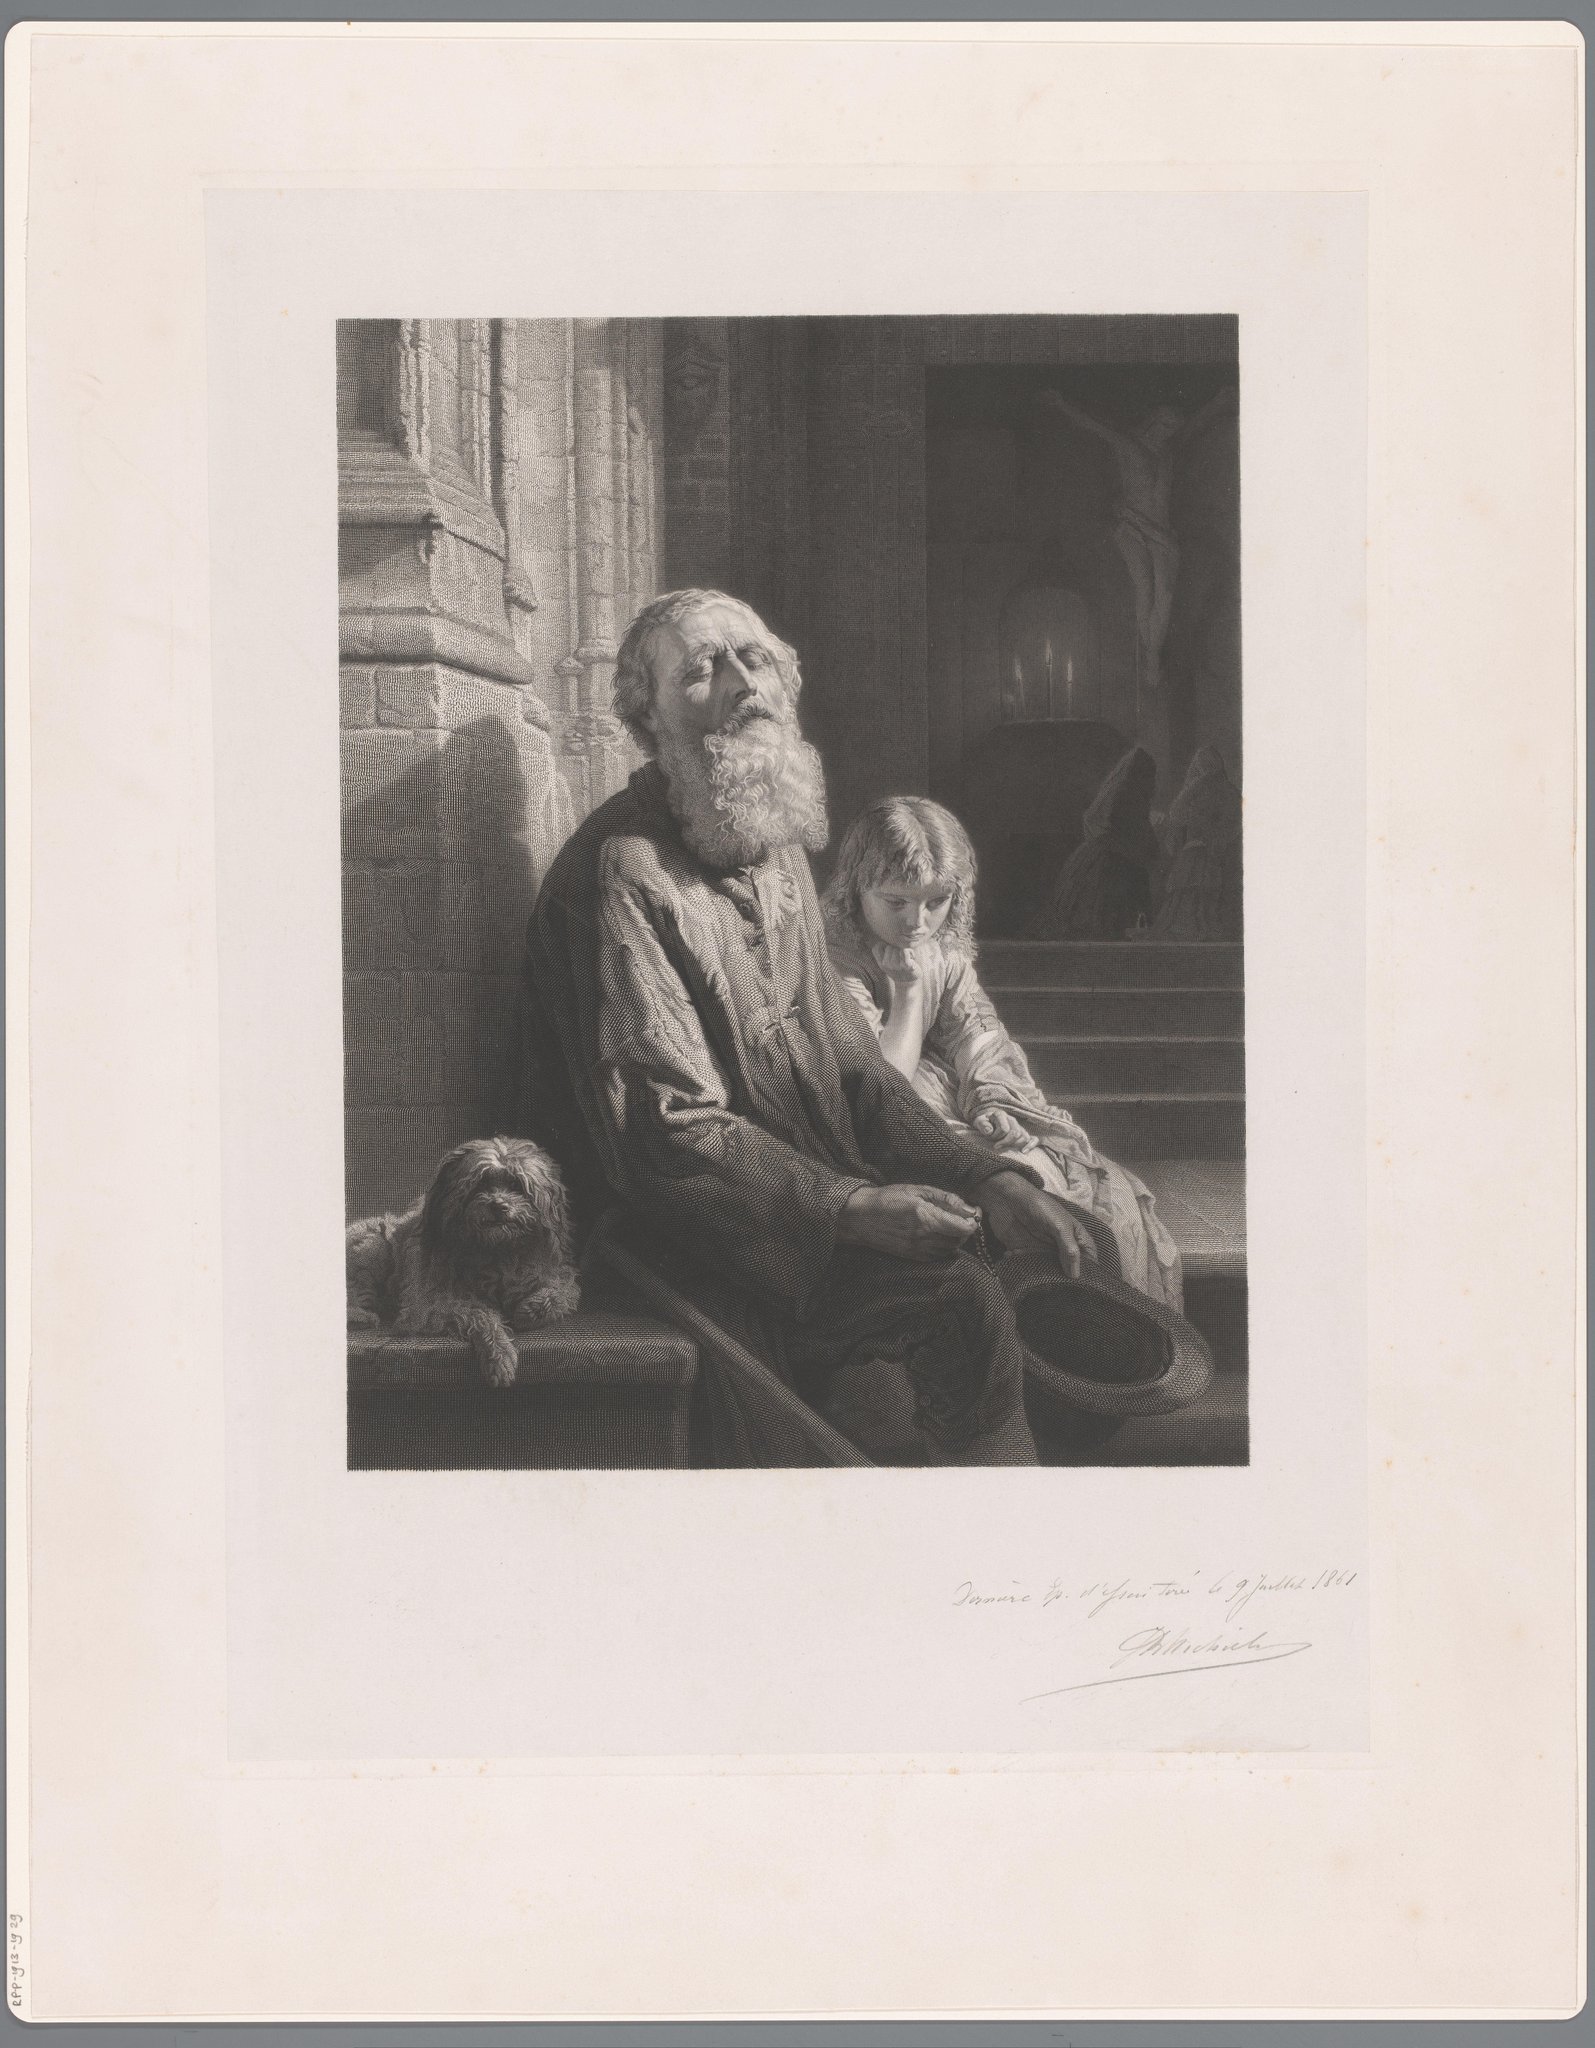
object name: print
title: Blinde bedelaar met hond en kind op de trap voor een kapel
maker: jean baptiste pierre michiels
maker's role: print maker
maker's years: 1821-1890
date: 1861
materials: paper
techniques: engraving, etching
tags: child, blind, blindness, parts of church interior, beggar, dog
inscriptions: inscription: ‘Derniere Ep. dessui tiré le 9 juillet 1861’, collector's mark: Lugt 2228